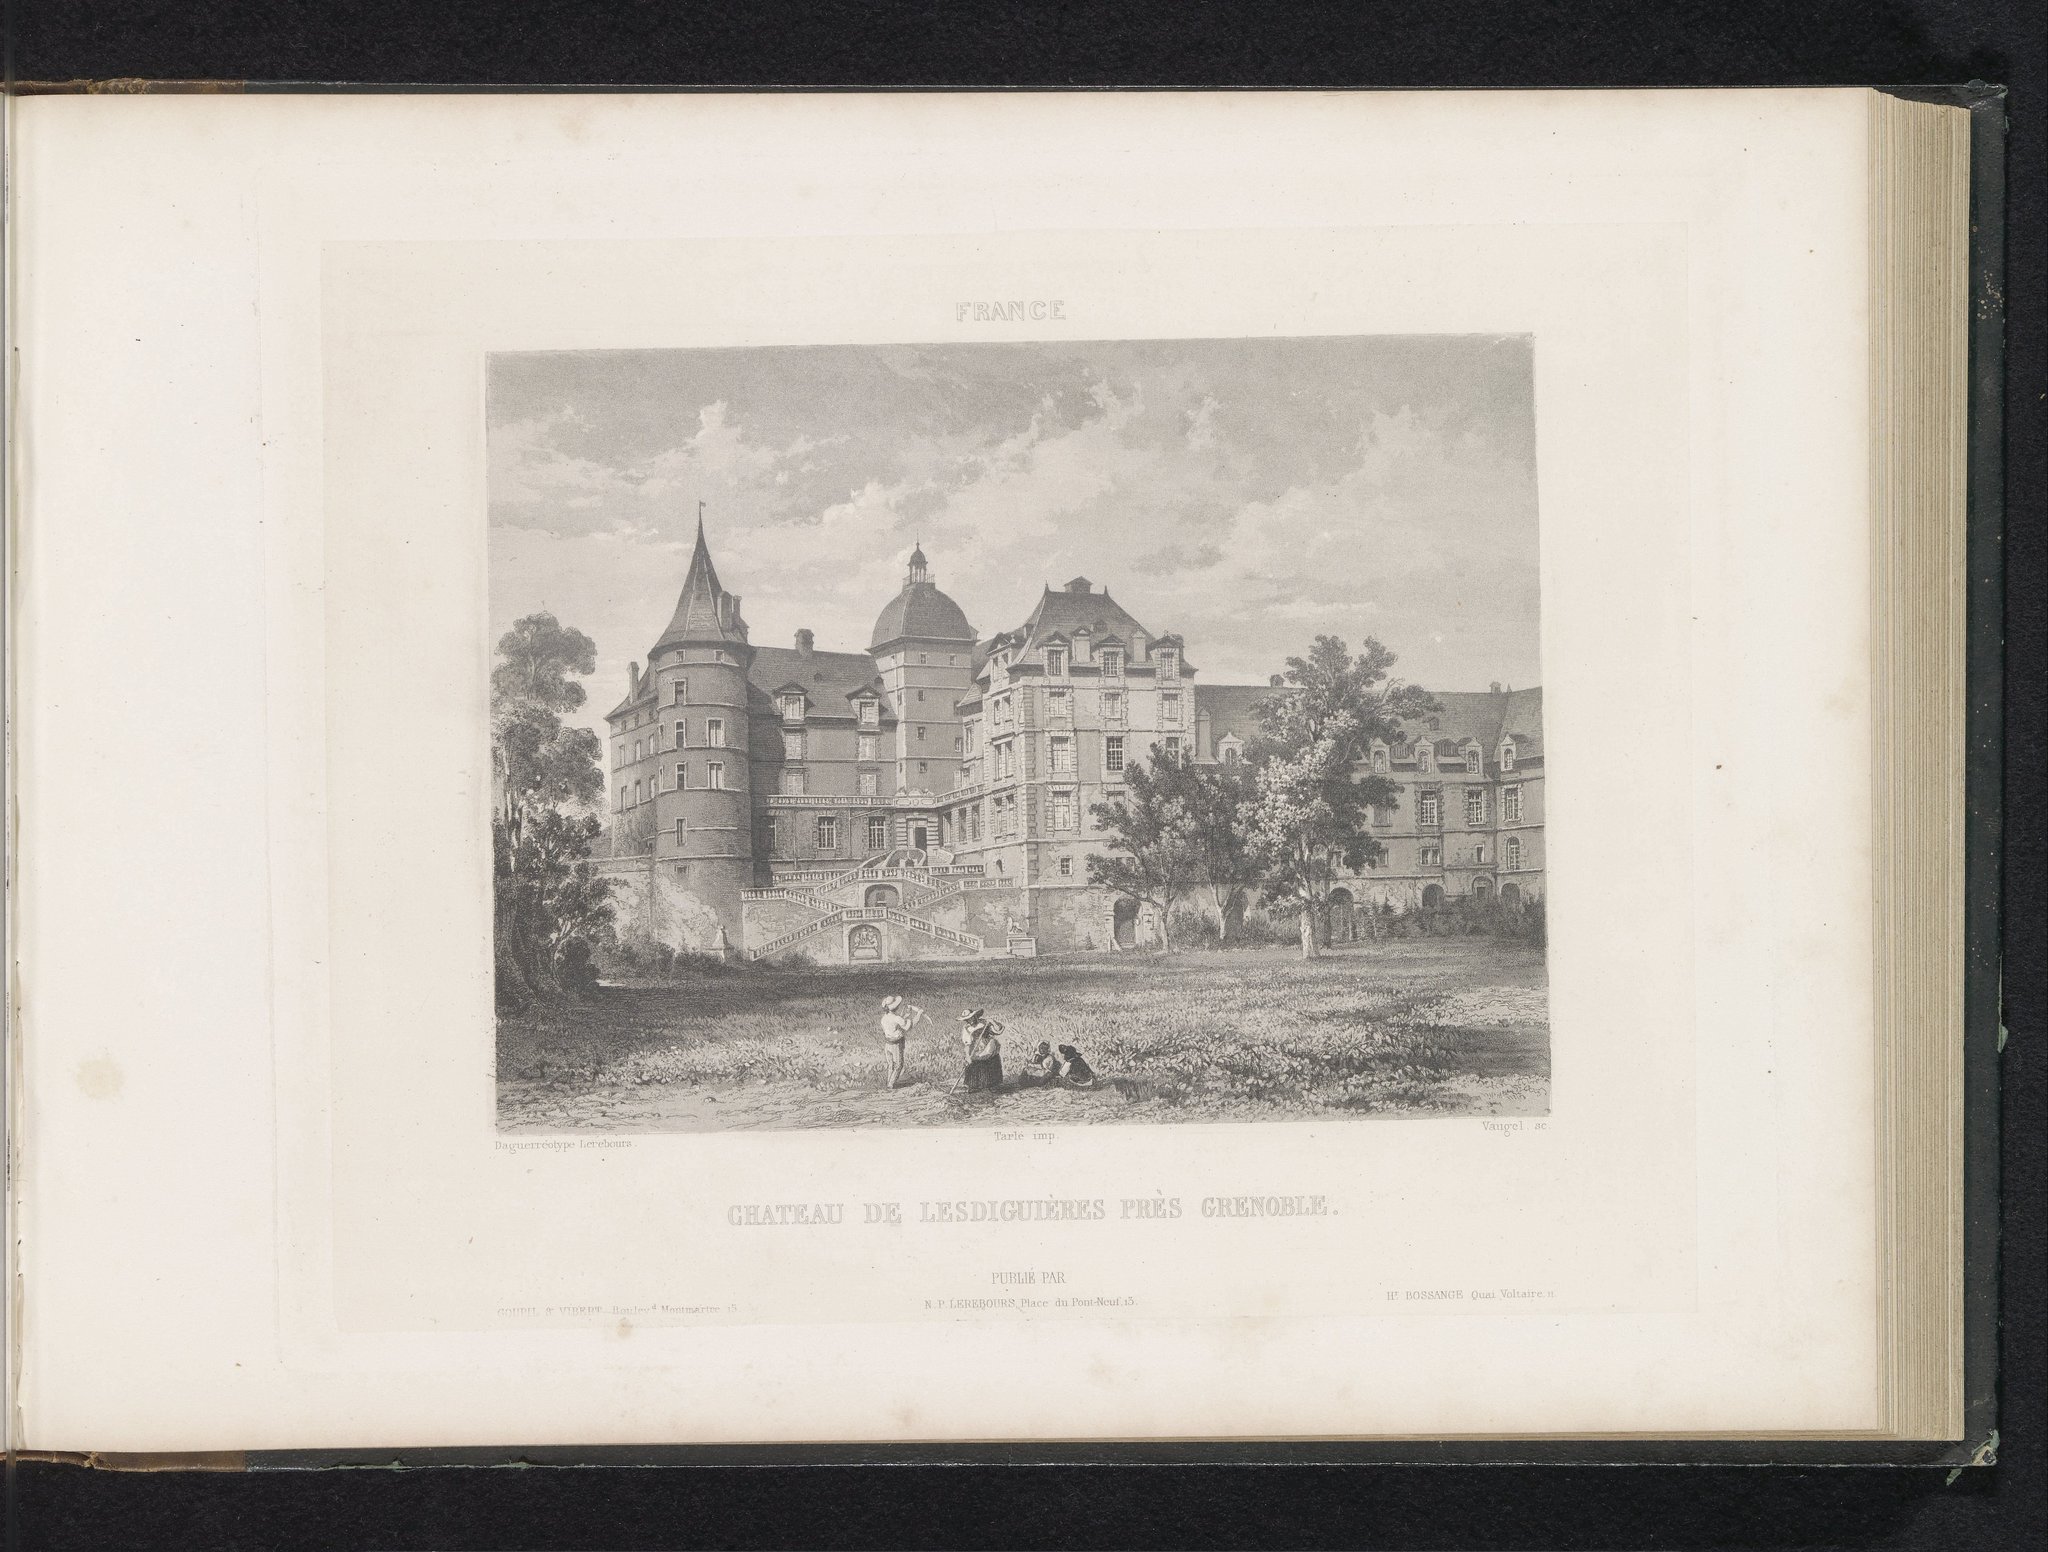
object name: print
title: Gezicht op Château Lesdiguières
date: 1839-1841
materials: paper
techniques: aquatint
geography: paris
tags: palace, façade (of house or building)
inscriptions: inscription: ‘Rittner & Goupil Boulevd Montmartre 15’, inscription: ‘Hr. Bossance Quai Voltaire 11’, inscription: ‘N.P. Lerebours Place du Pont Neuf 15’